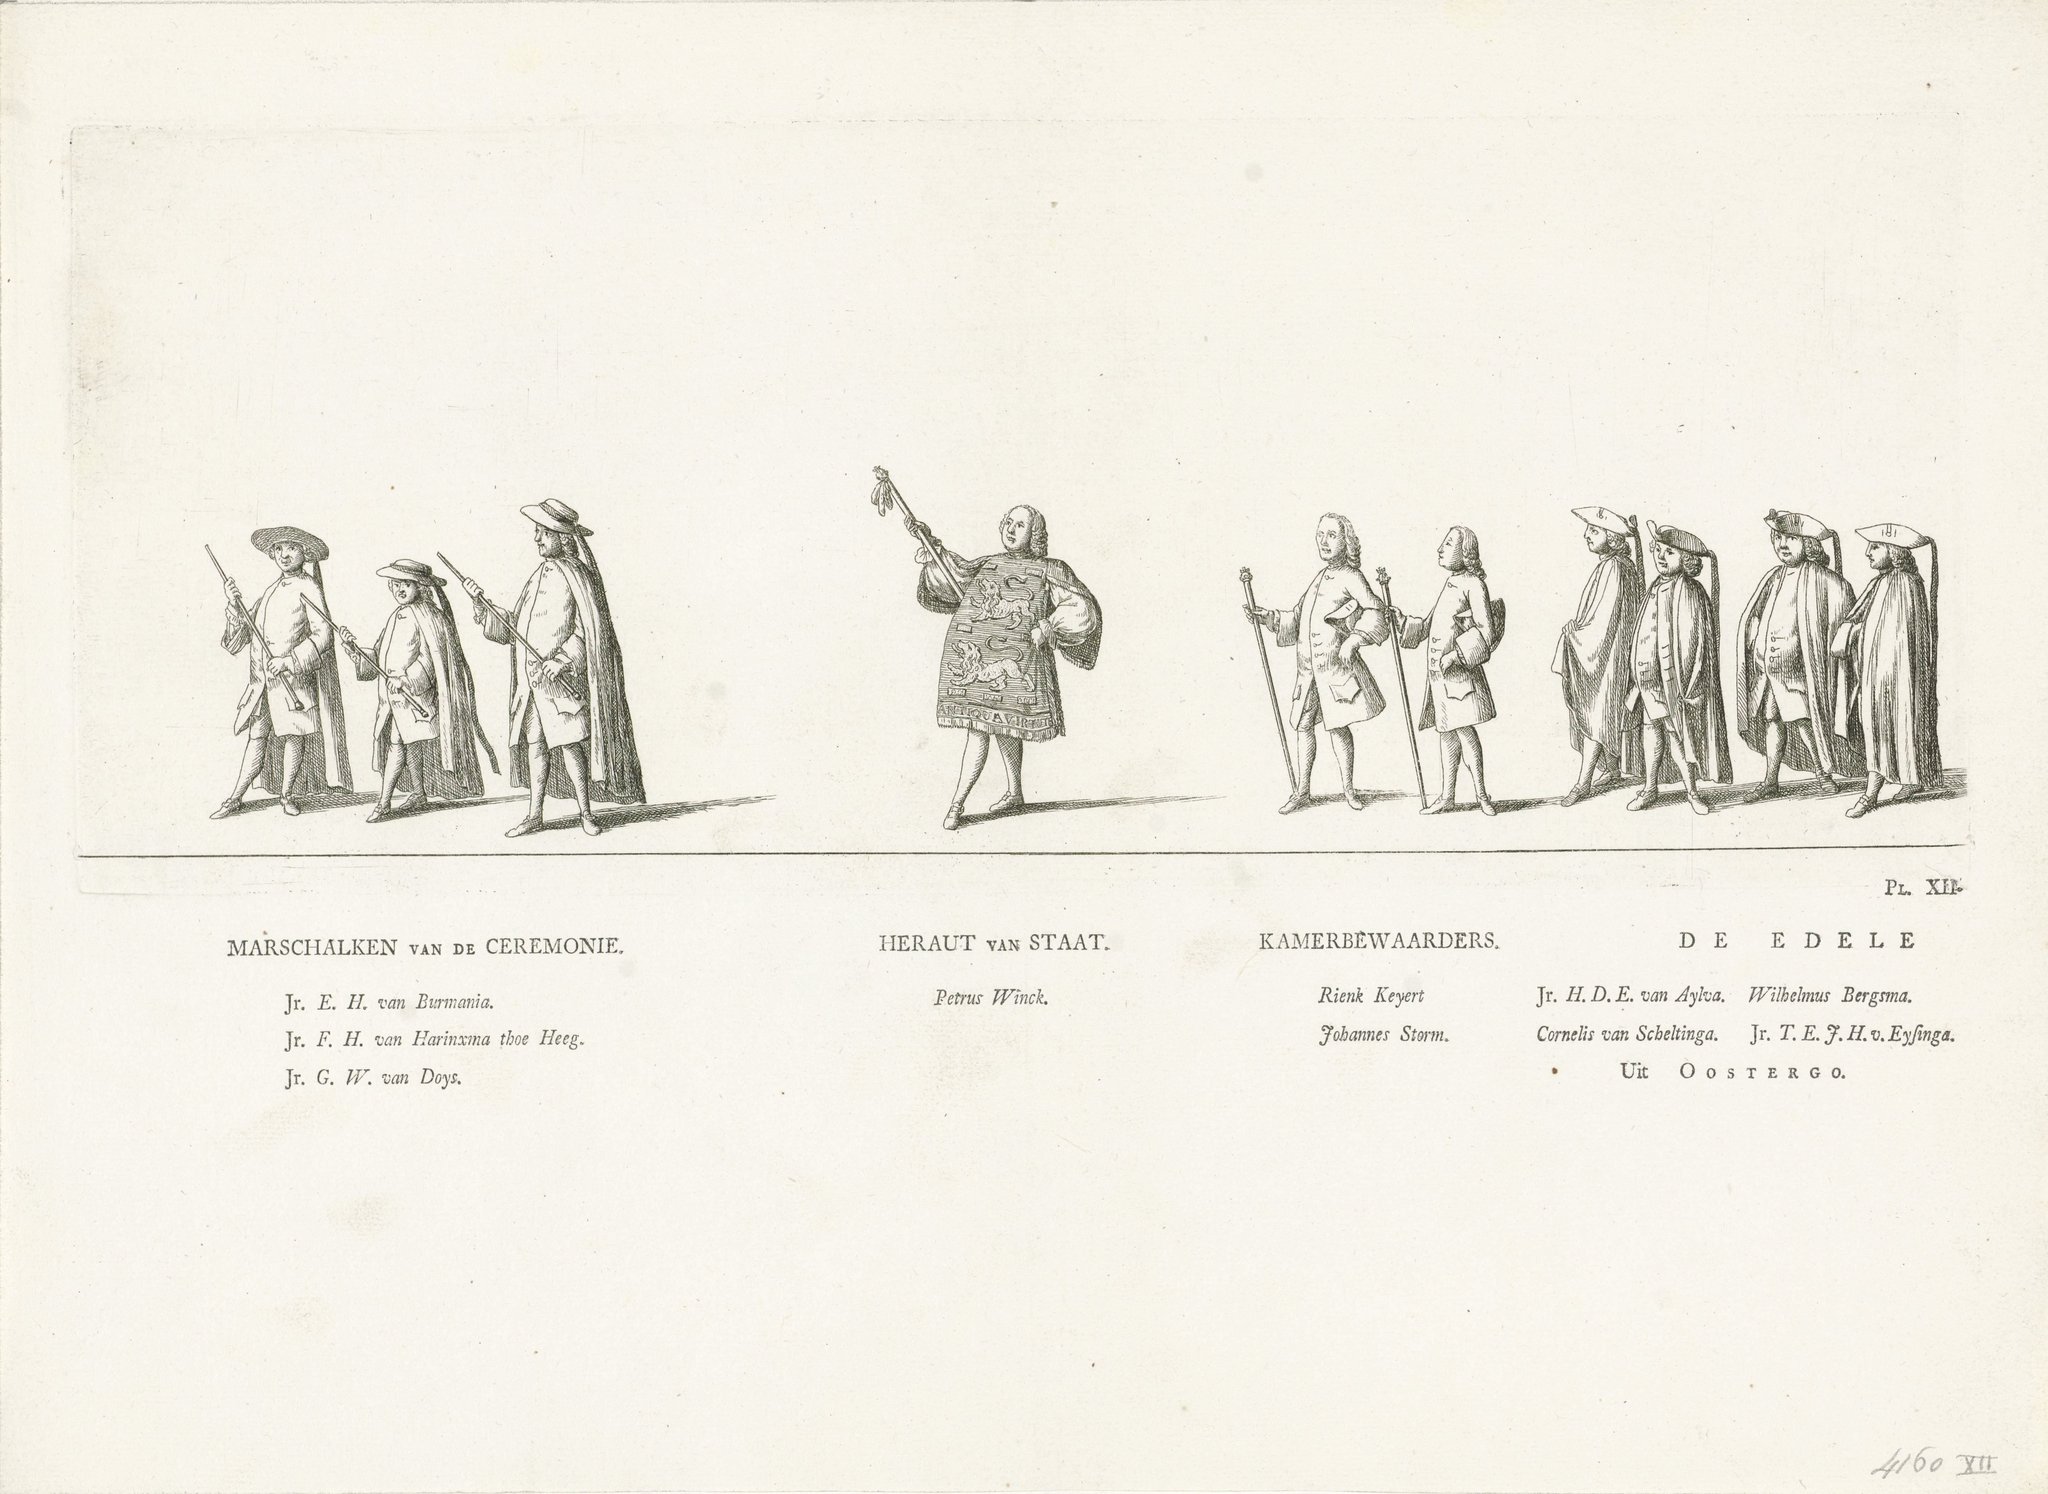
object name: print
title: Verschillende personen in de begrafenisstoet van prinses Maria Louise, 1765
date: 1765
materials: paper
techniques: etching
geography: leeuwarden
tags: cortege, funeral procession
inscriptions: date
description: Verschillende personen. Gemerkt rechtsonder: Pl. XII. Op het blad onder de plaat de namen van personen in de stoet. Onderdeel van de serie platen van de begrafenis van prinses Maria Louise te Leeuwarden op 13 juni 1765.